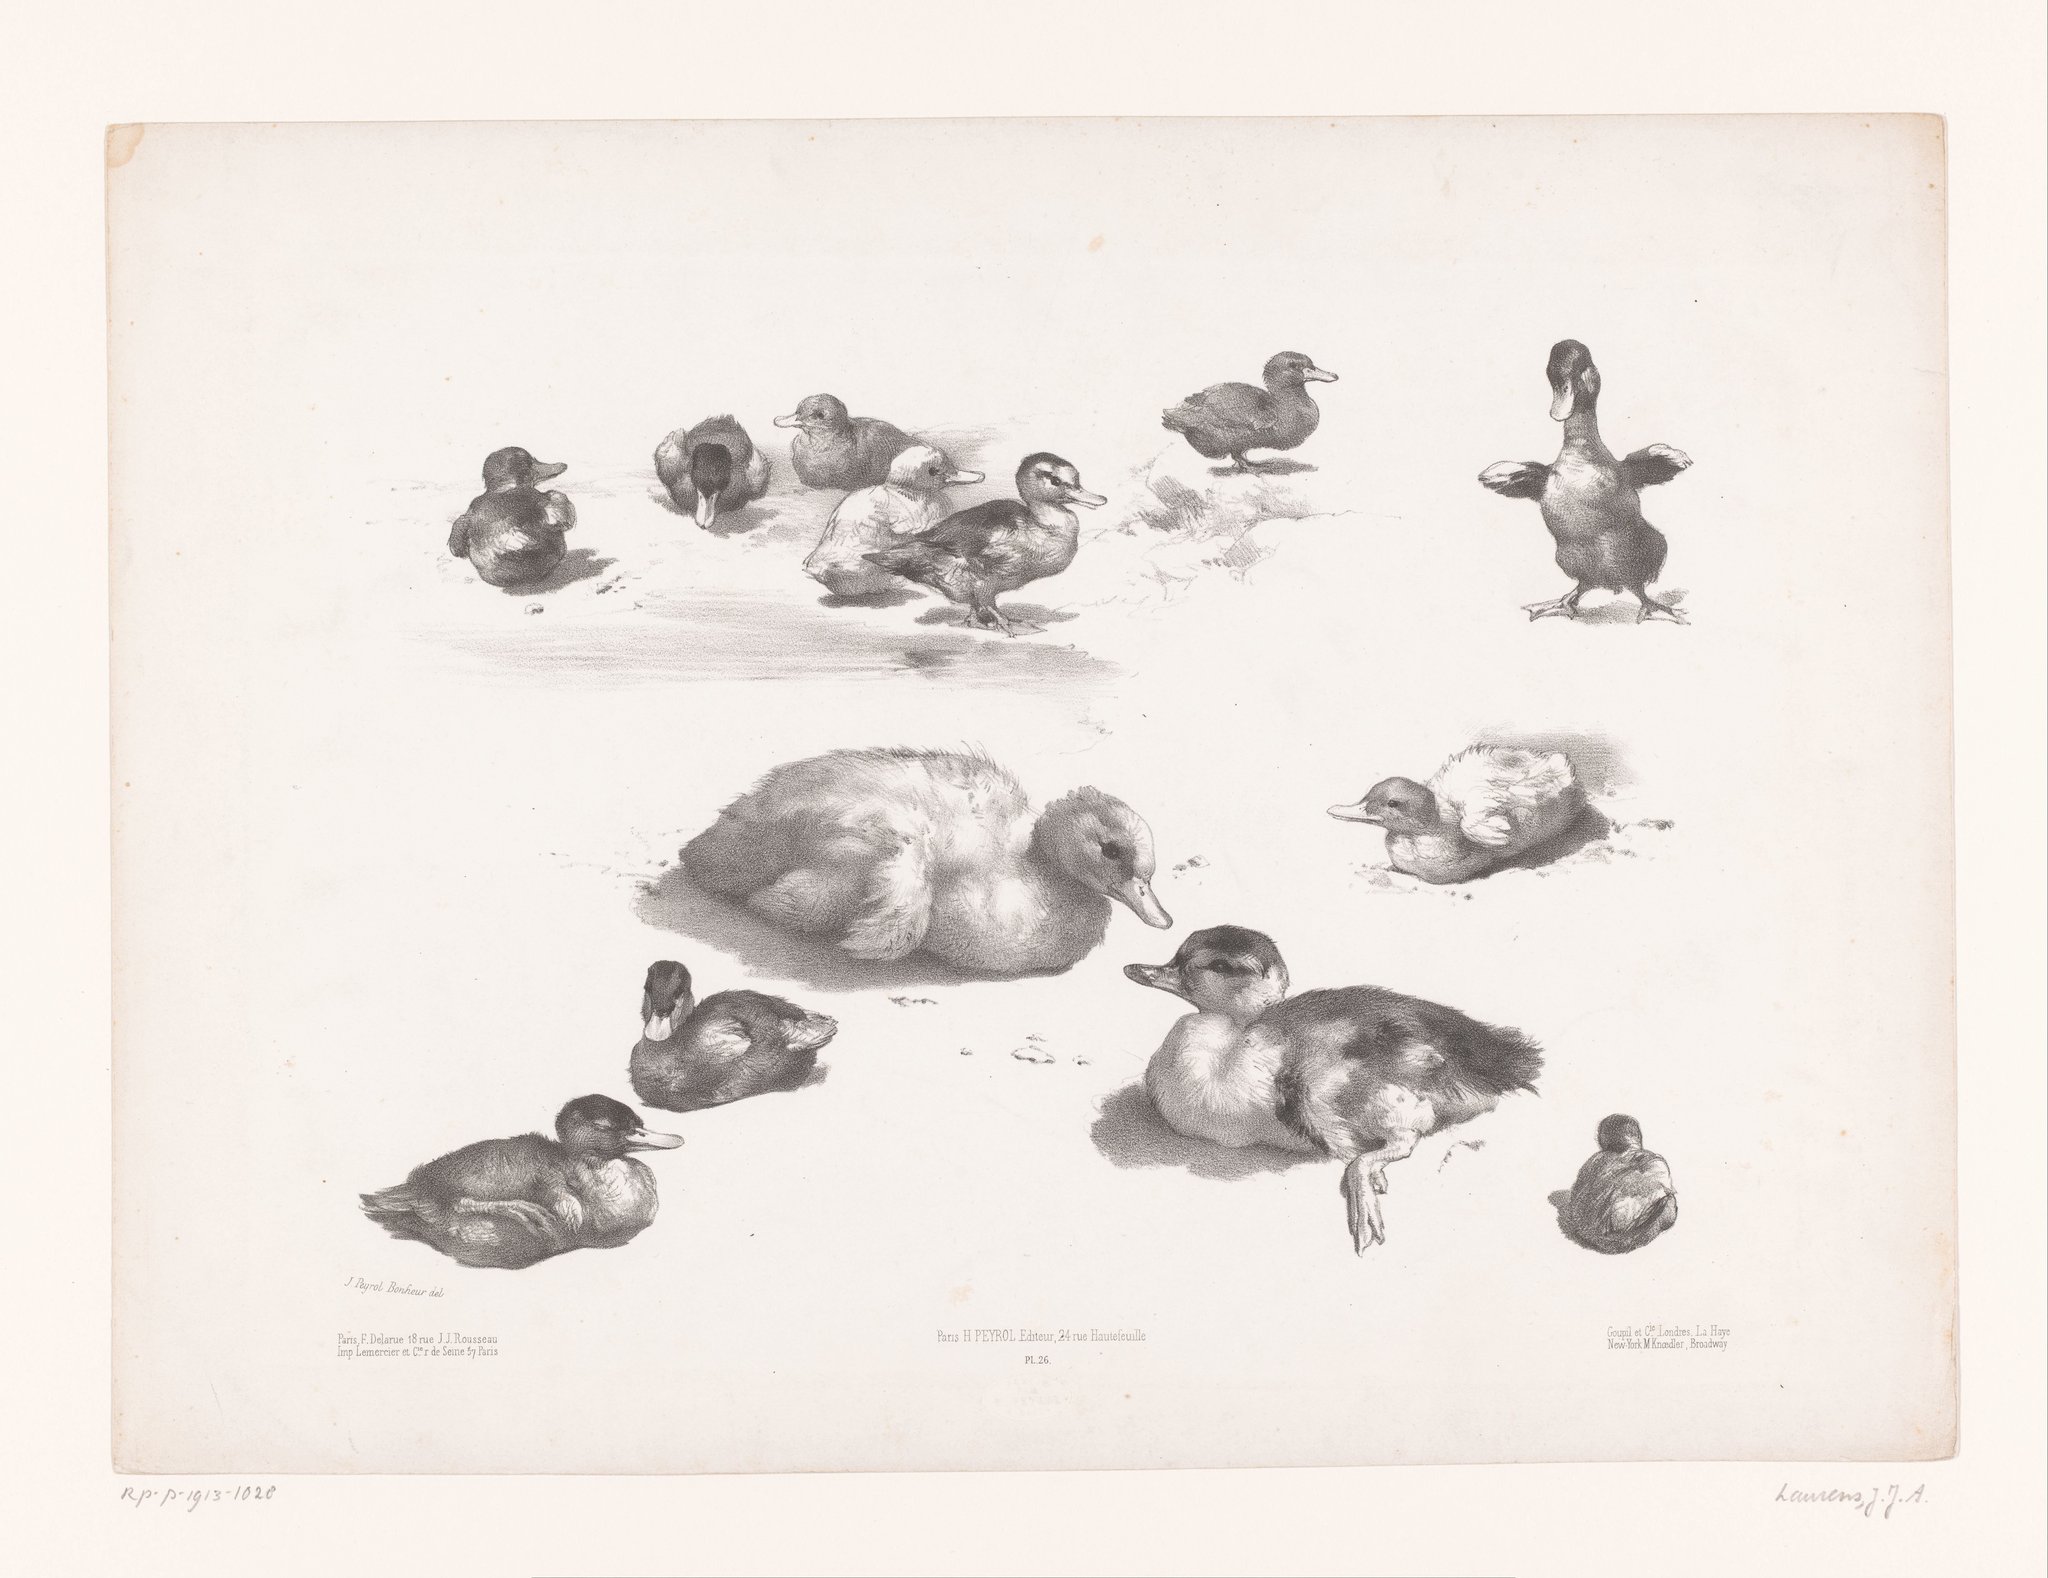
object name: print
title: Petites études d'animaux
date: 1865-1878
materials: paper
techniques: lithograph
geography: paris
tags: water-birds: duck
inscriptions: collector's mark: Lugt 2228a, check stamp: Lugt 4777